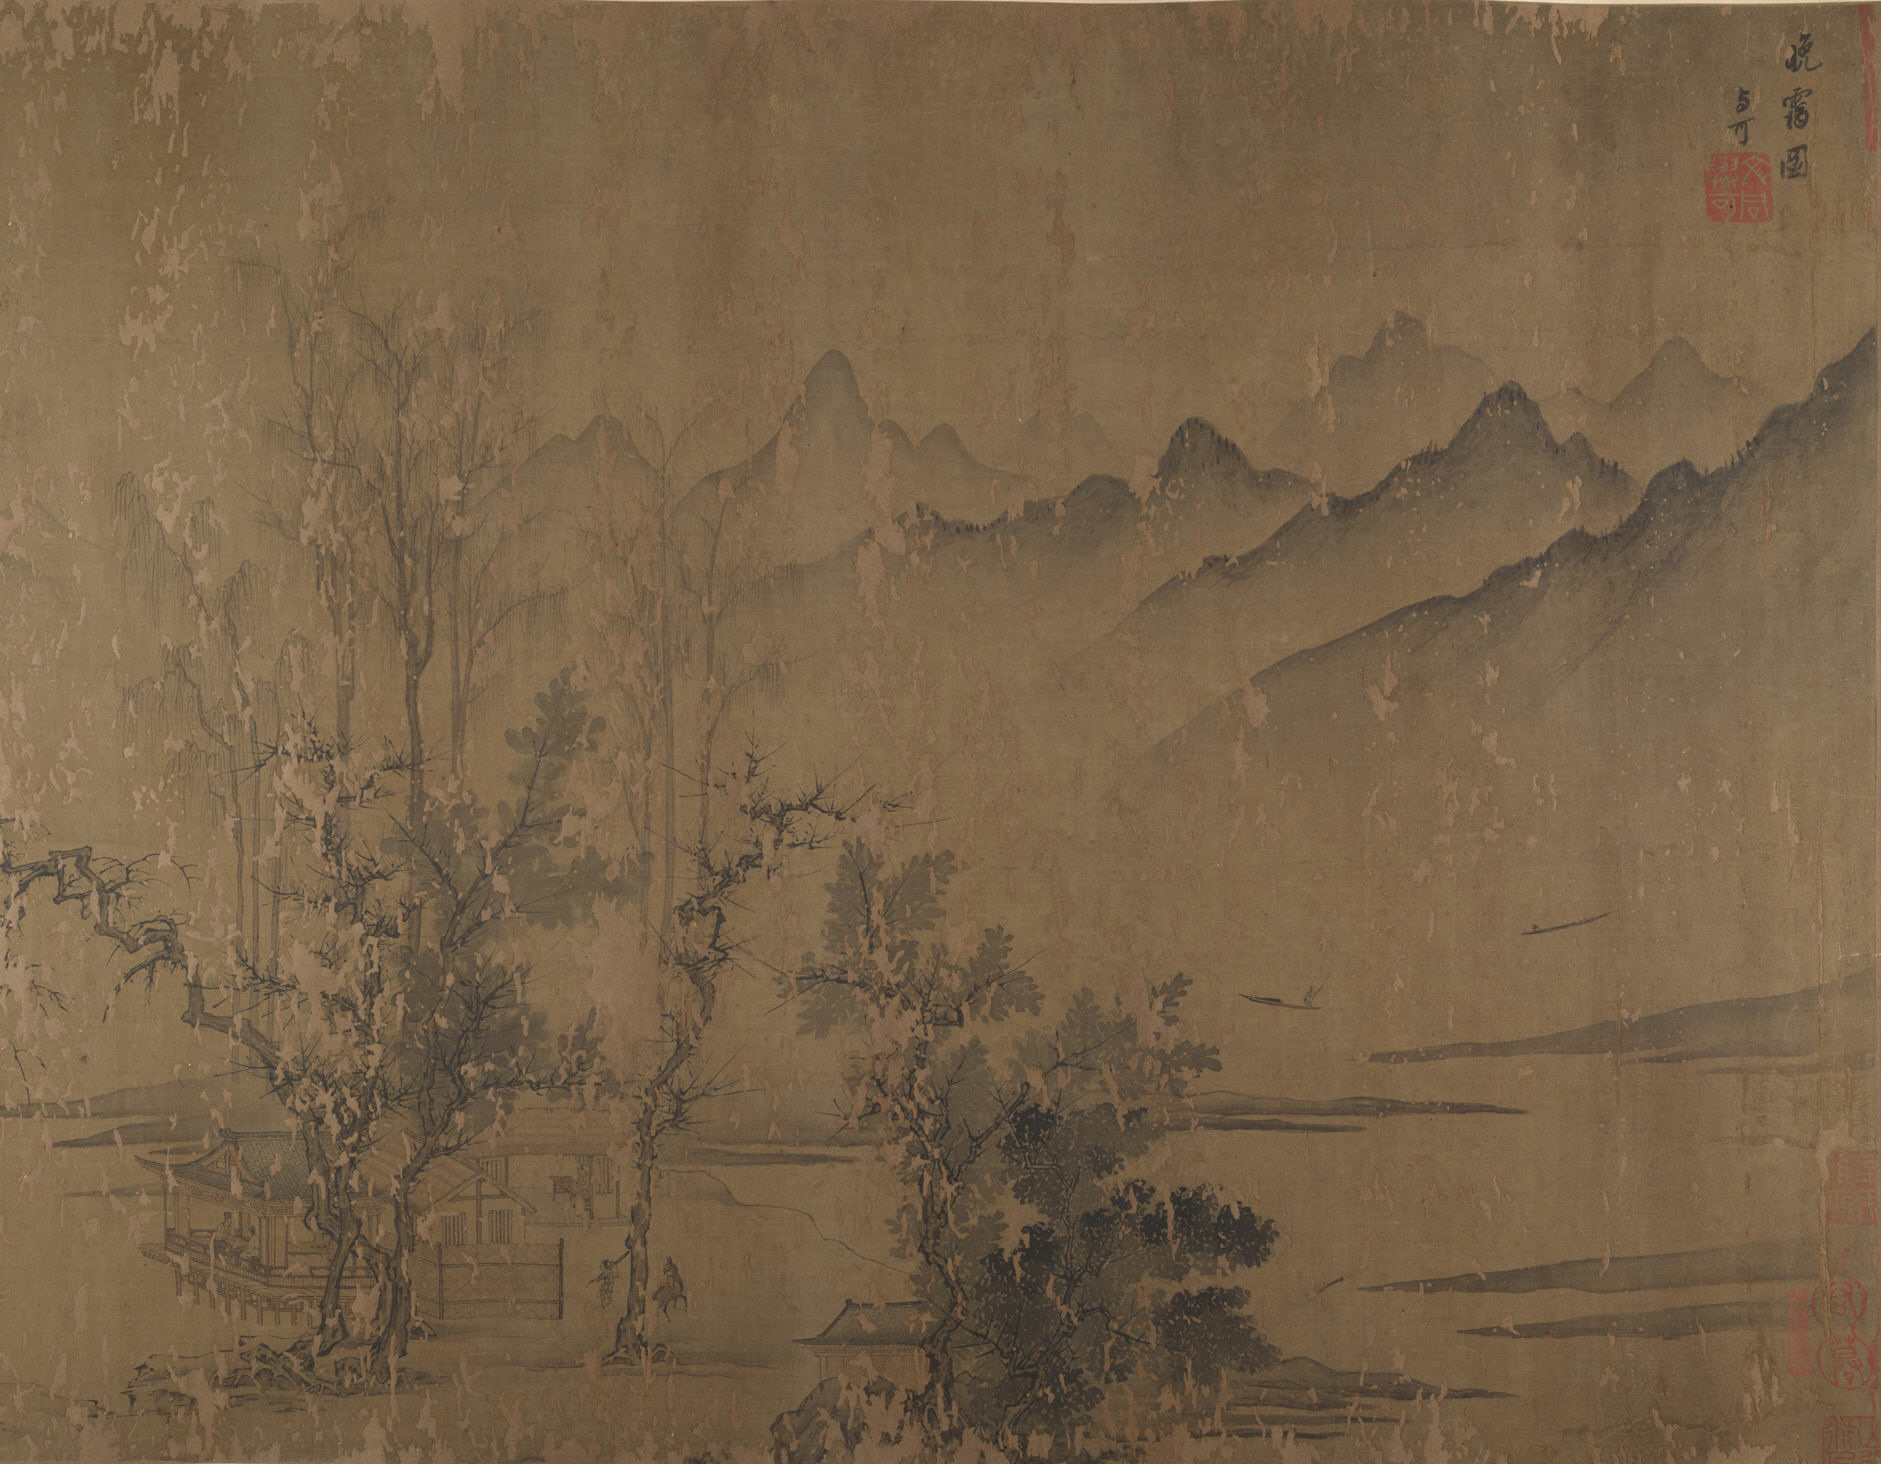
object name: handscroll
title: Rosy Sunset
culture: chinese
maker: wen tong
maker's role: artist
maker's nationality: chinese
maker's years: 1019-1079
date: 1501-1600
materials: ink, silk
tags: mountains,landscapes